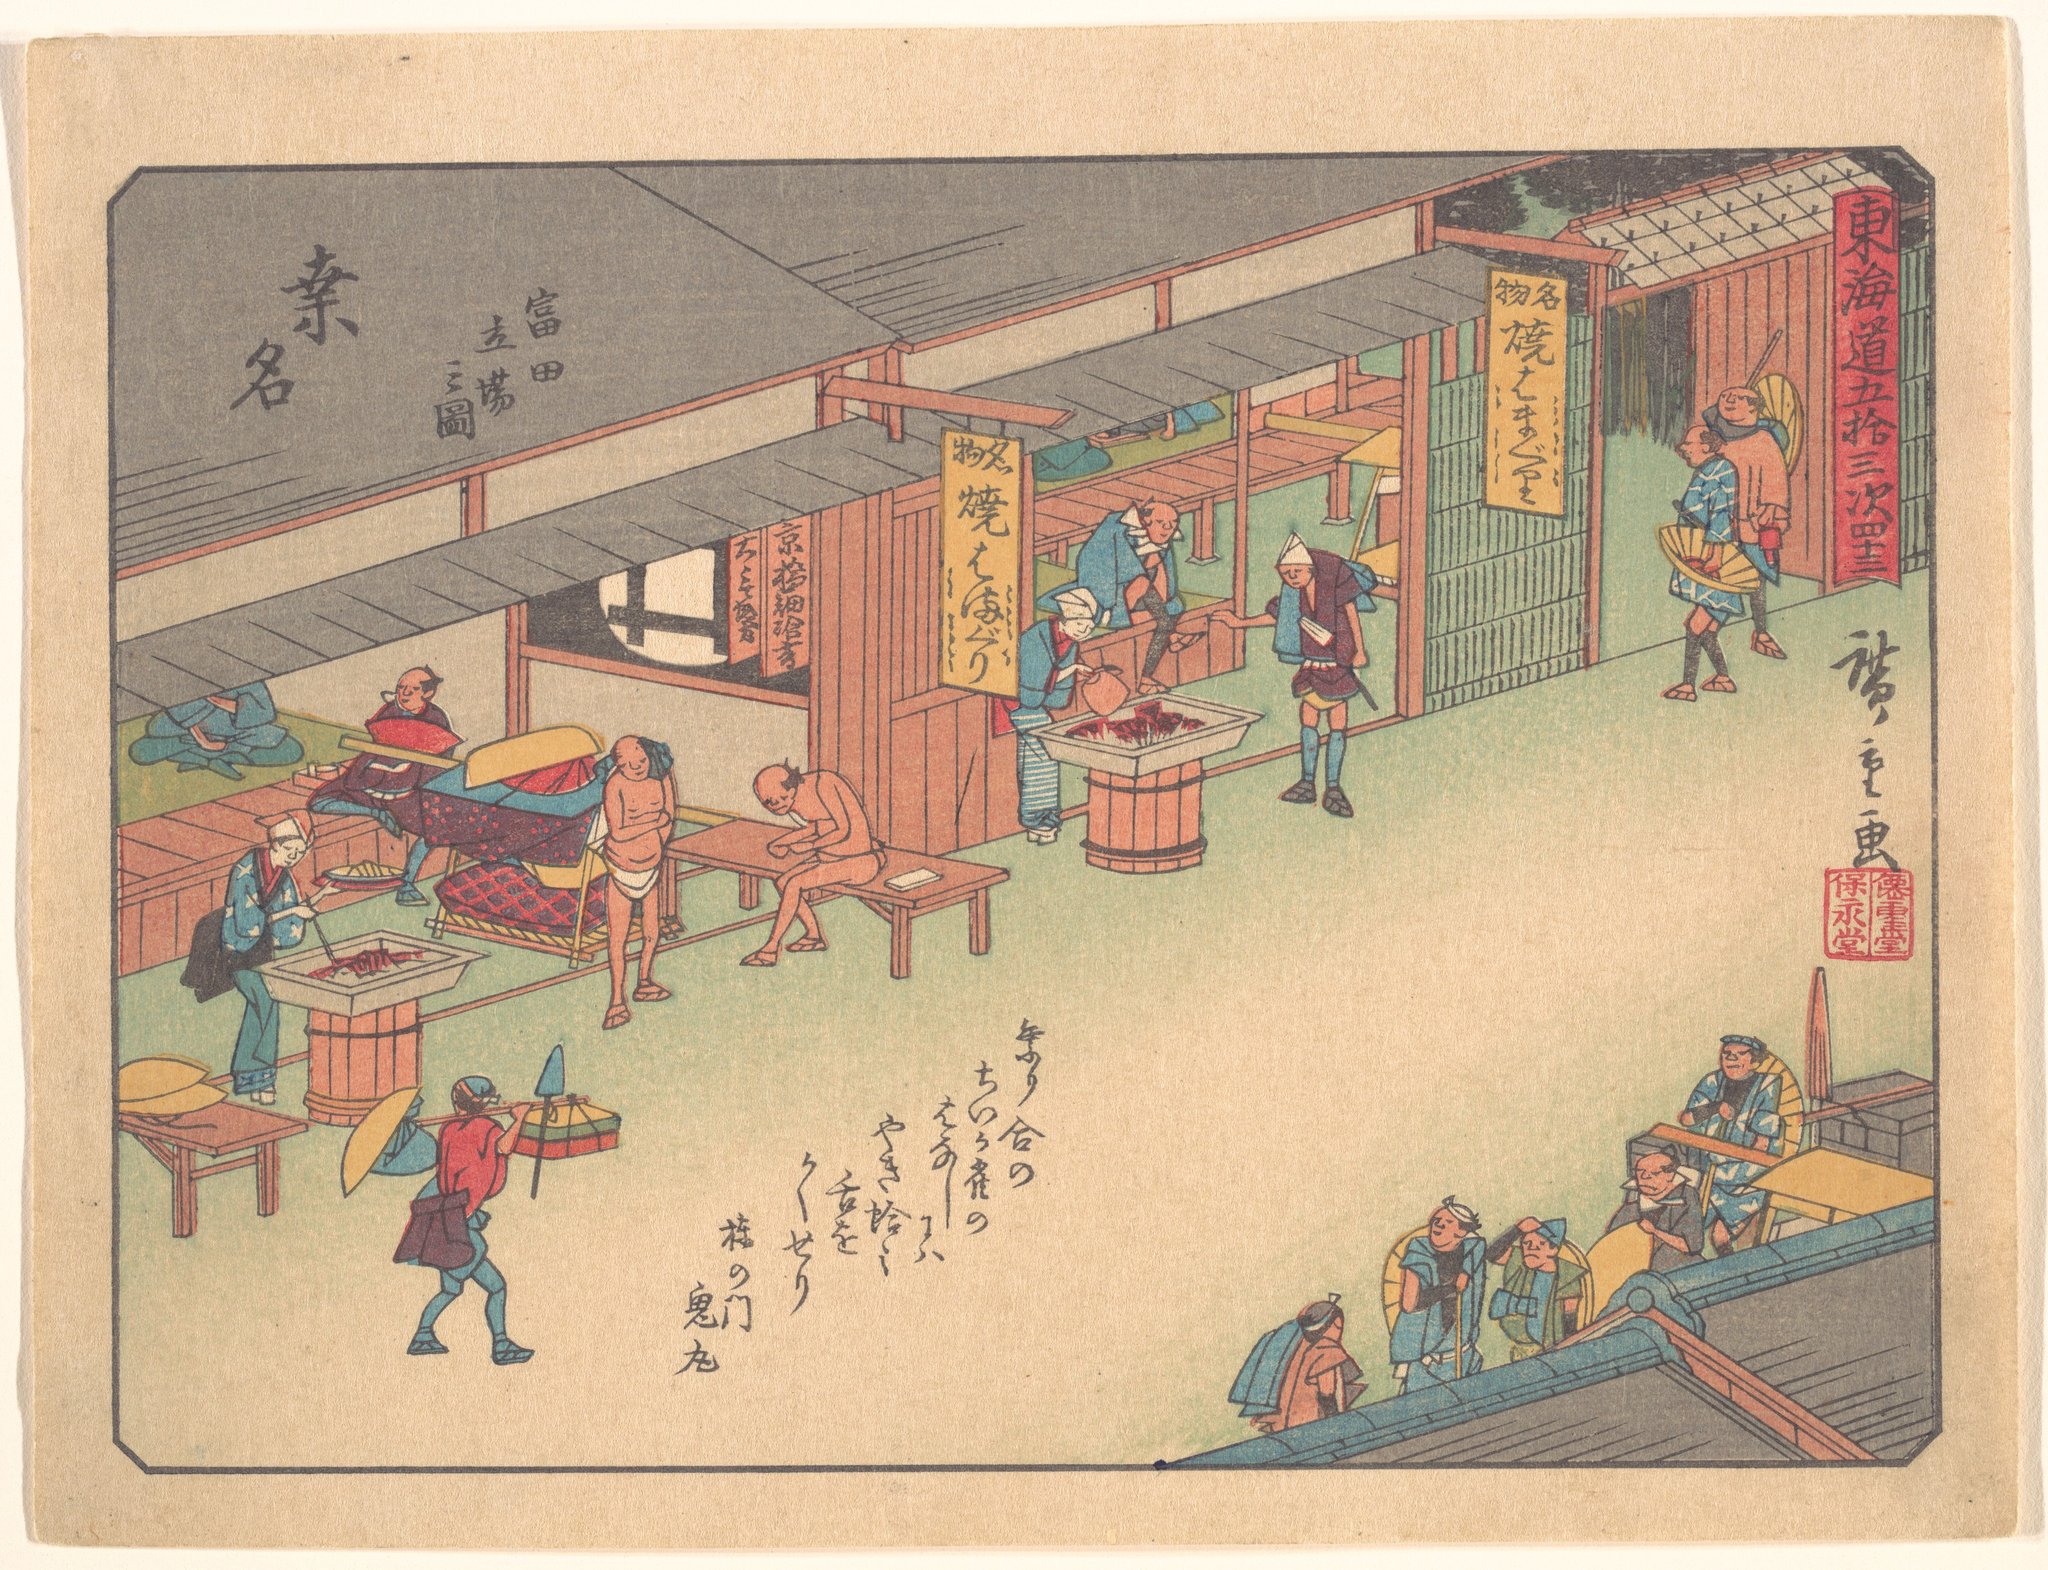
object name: print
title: Kuwana, from the series The Fifty-three Stations of the Tōkaidō Road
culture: japanese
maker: utagawa hiroshige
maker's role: artist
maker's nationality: japanese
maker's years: 1797-1858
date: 1901-1933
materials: ink, paper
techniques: woodblock print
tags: human figures,markets